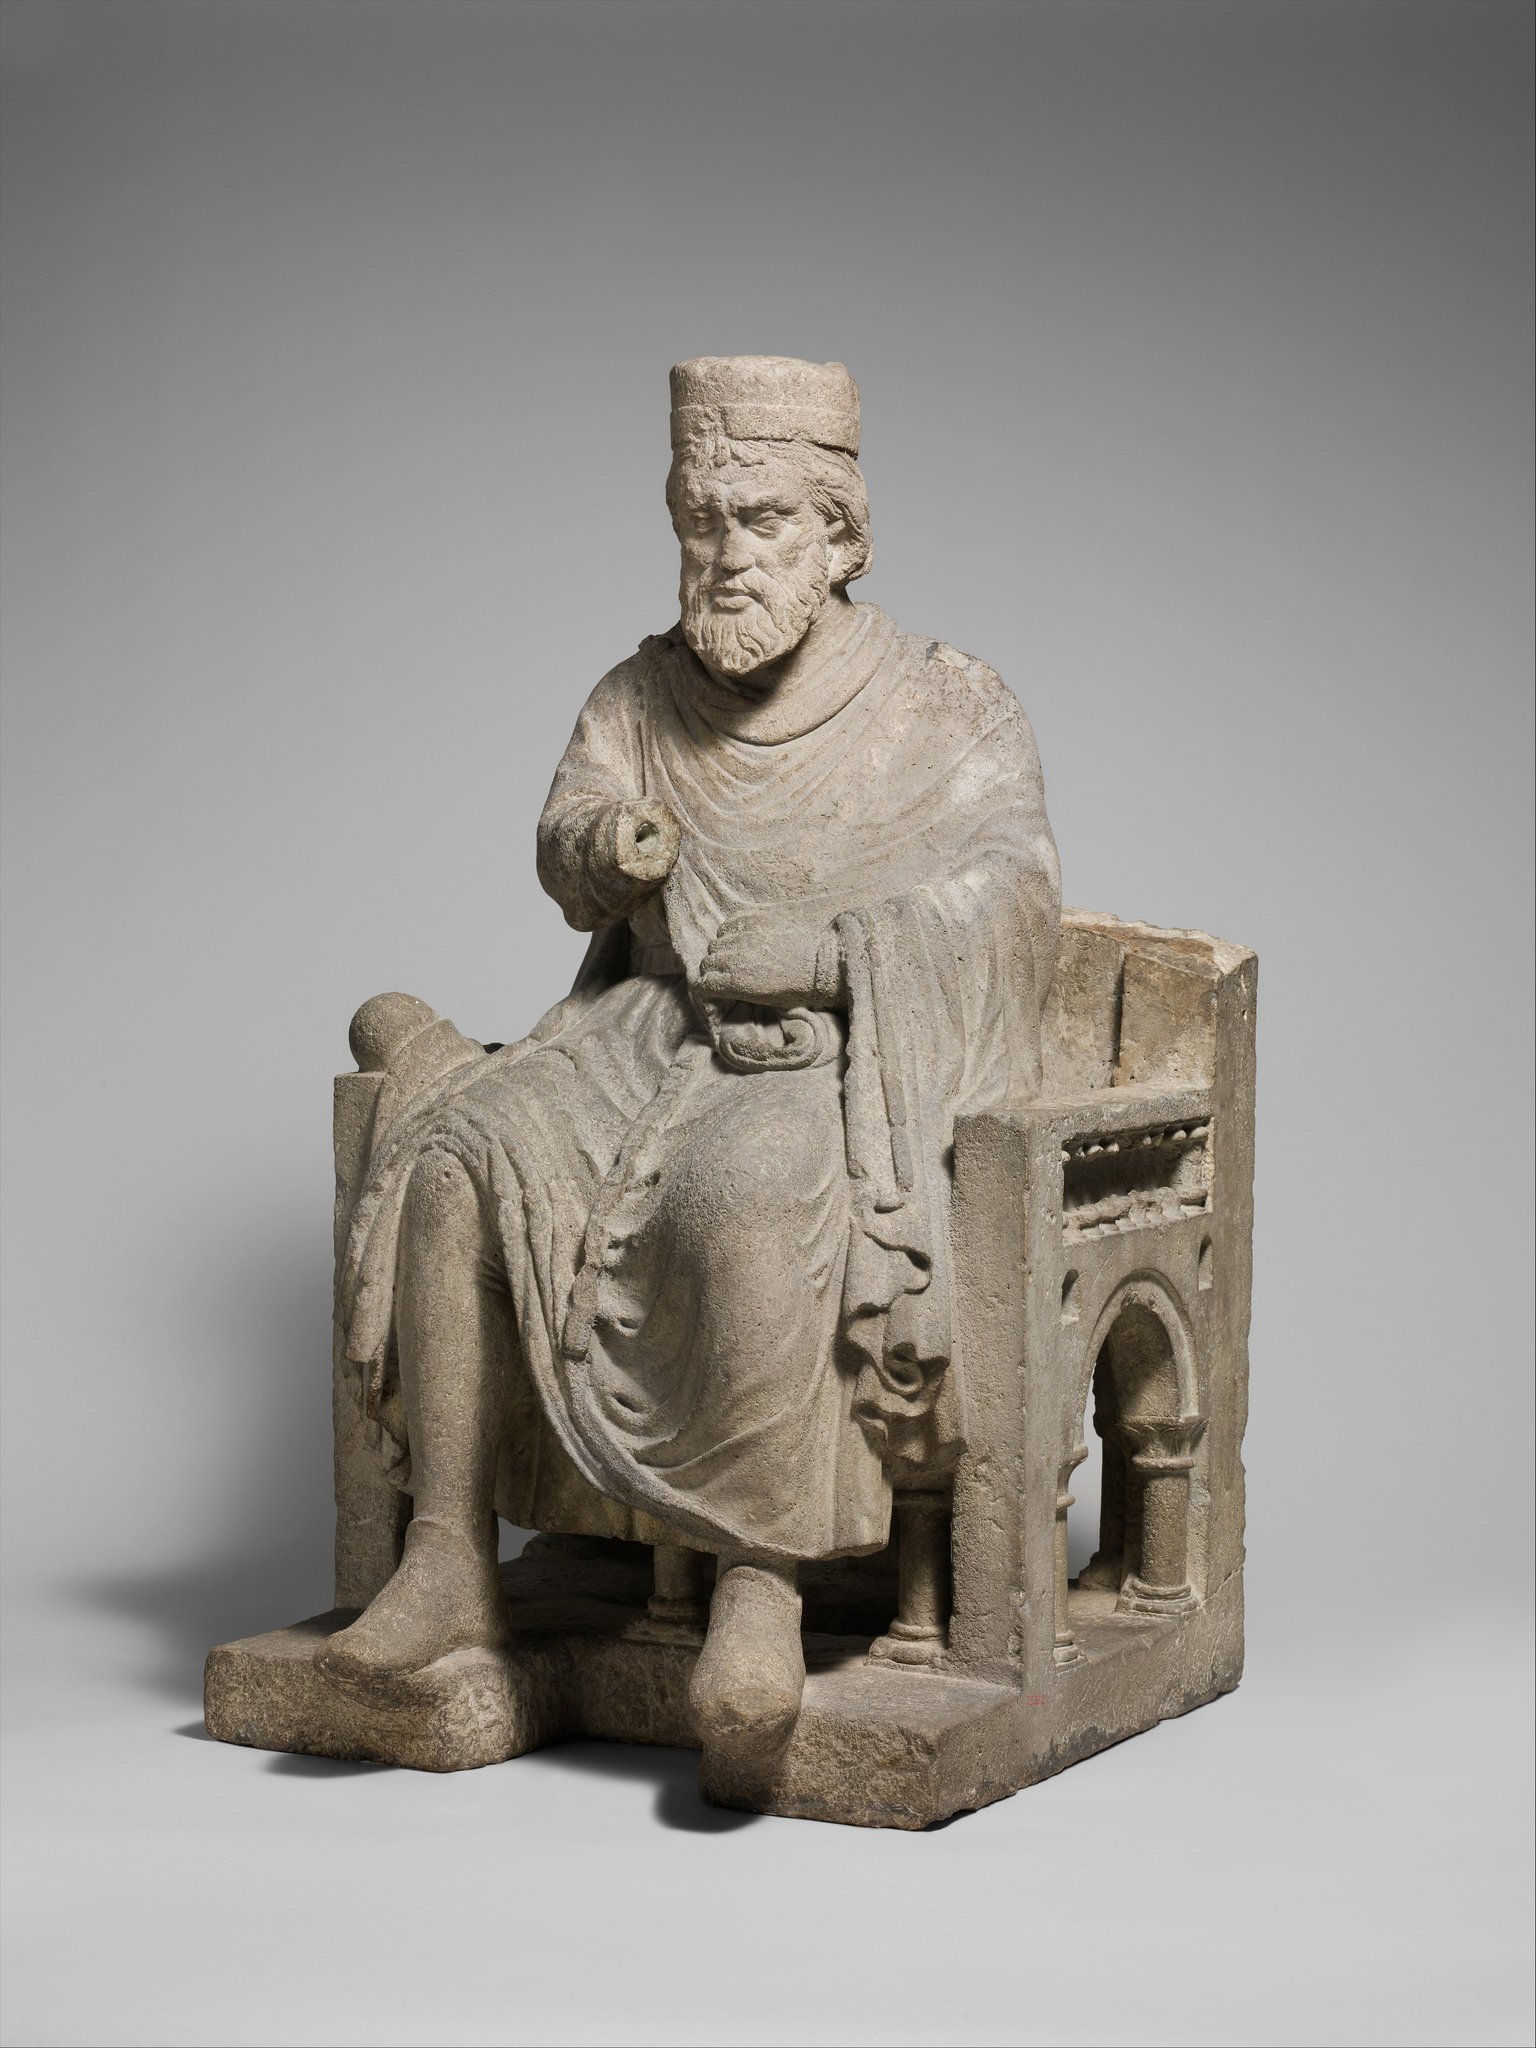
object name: statue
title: Sculpture of an Enthroned King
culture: north italian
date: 1230-1235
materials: limestone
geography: italy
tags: kings,men